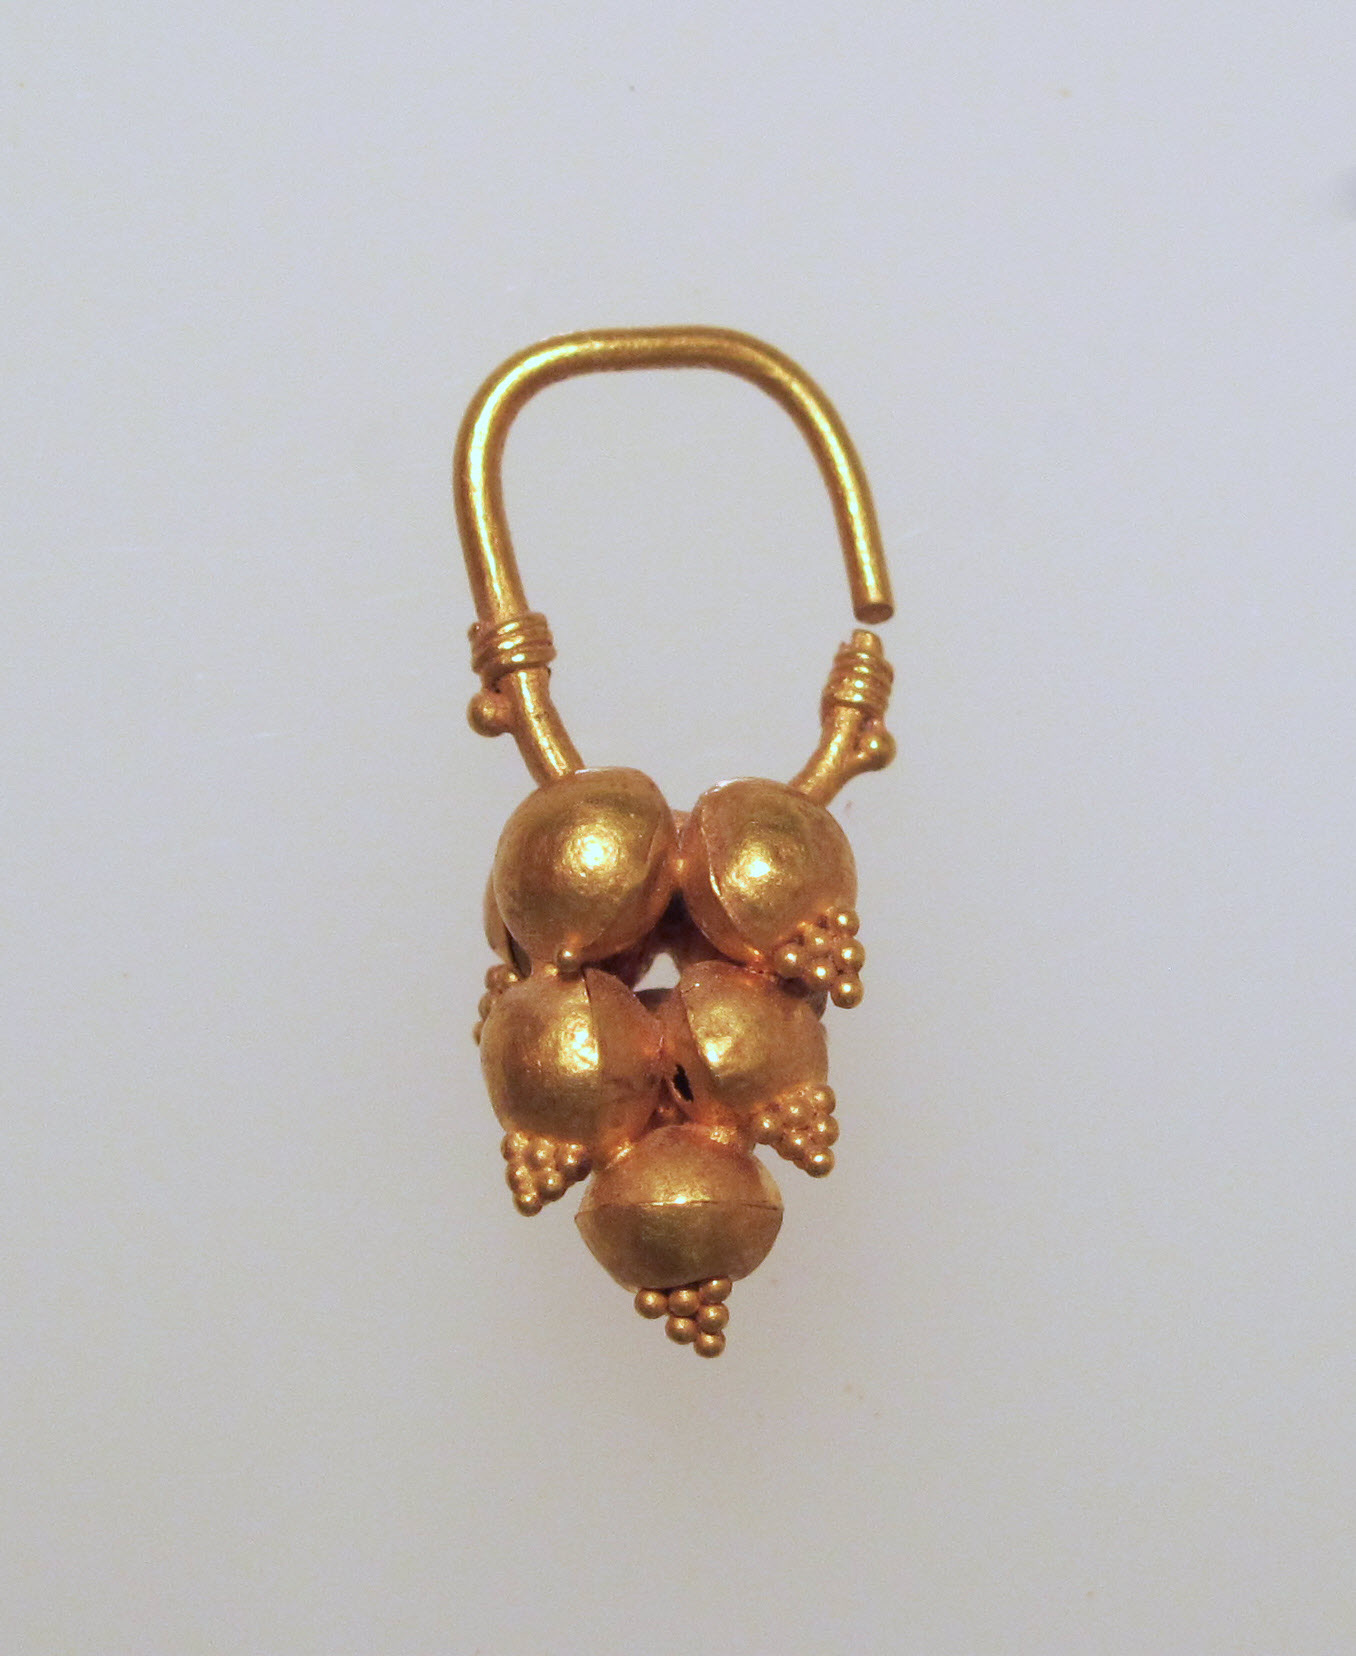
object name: earring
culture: roman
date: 101-300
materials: gold